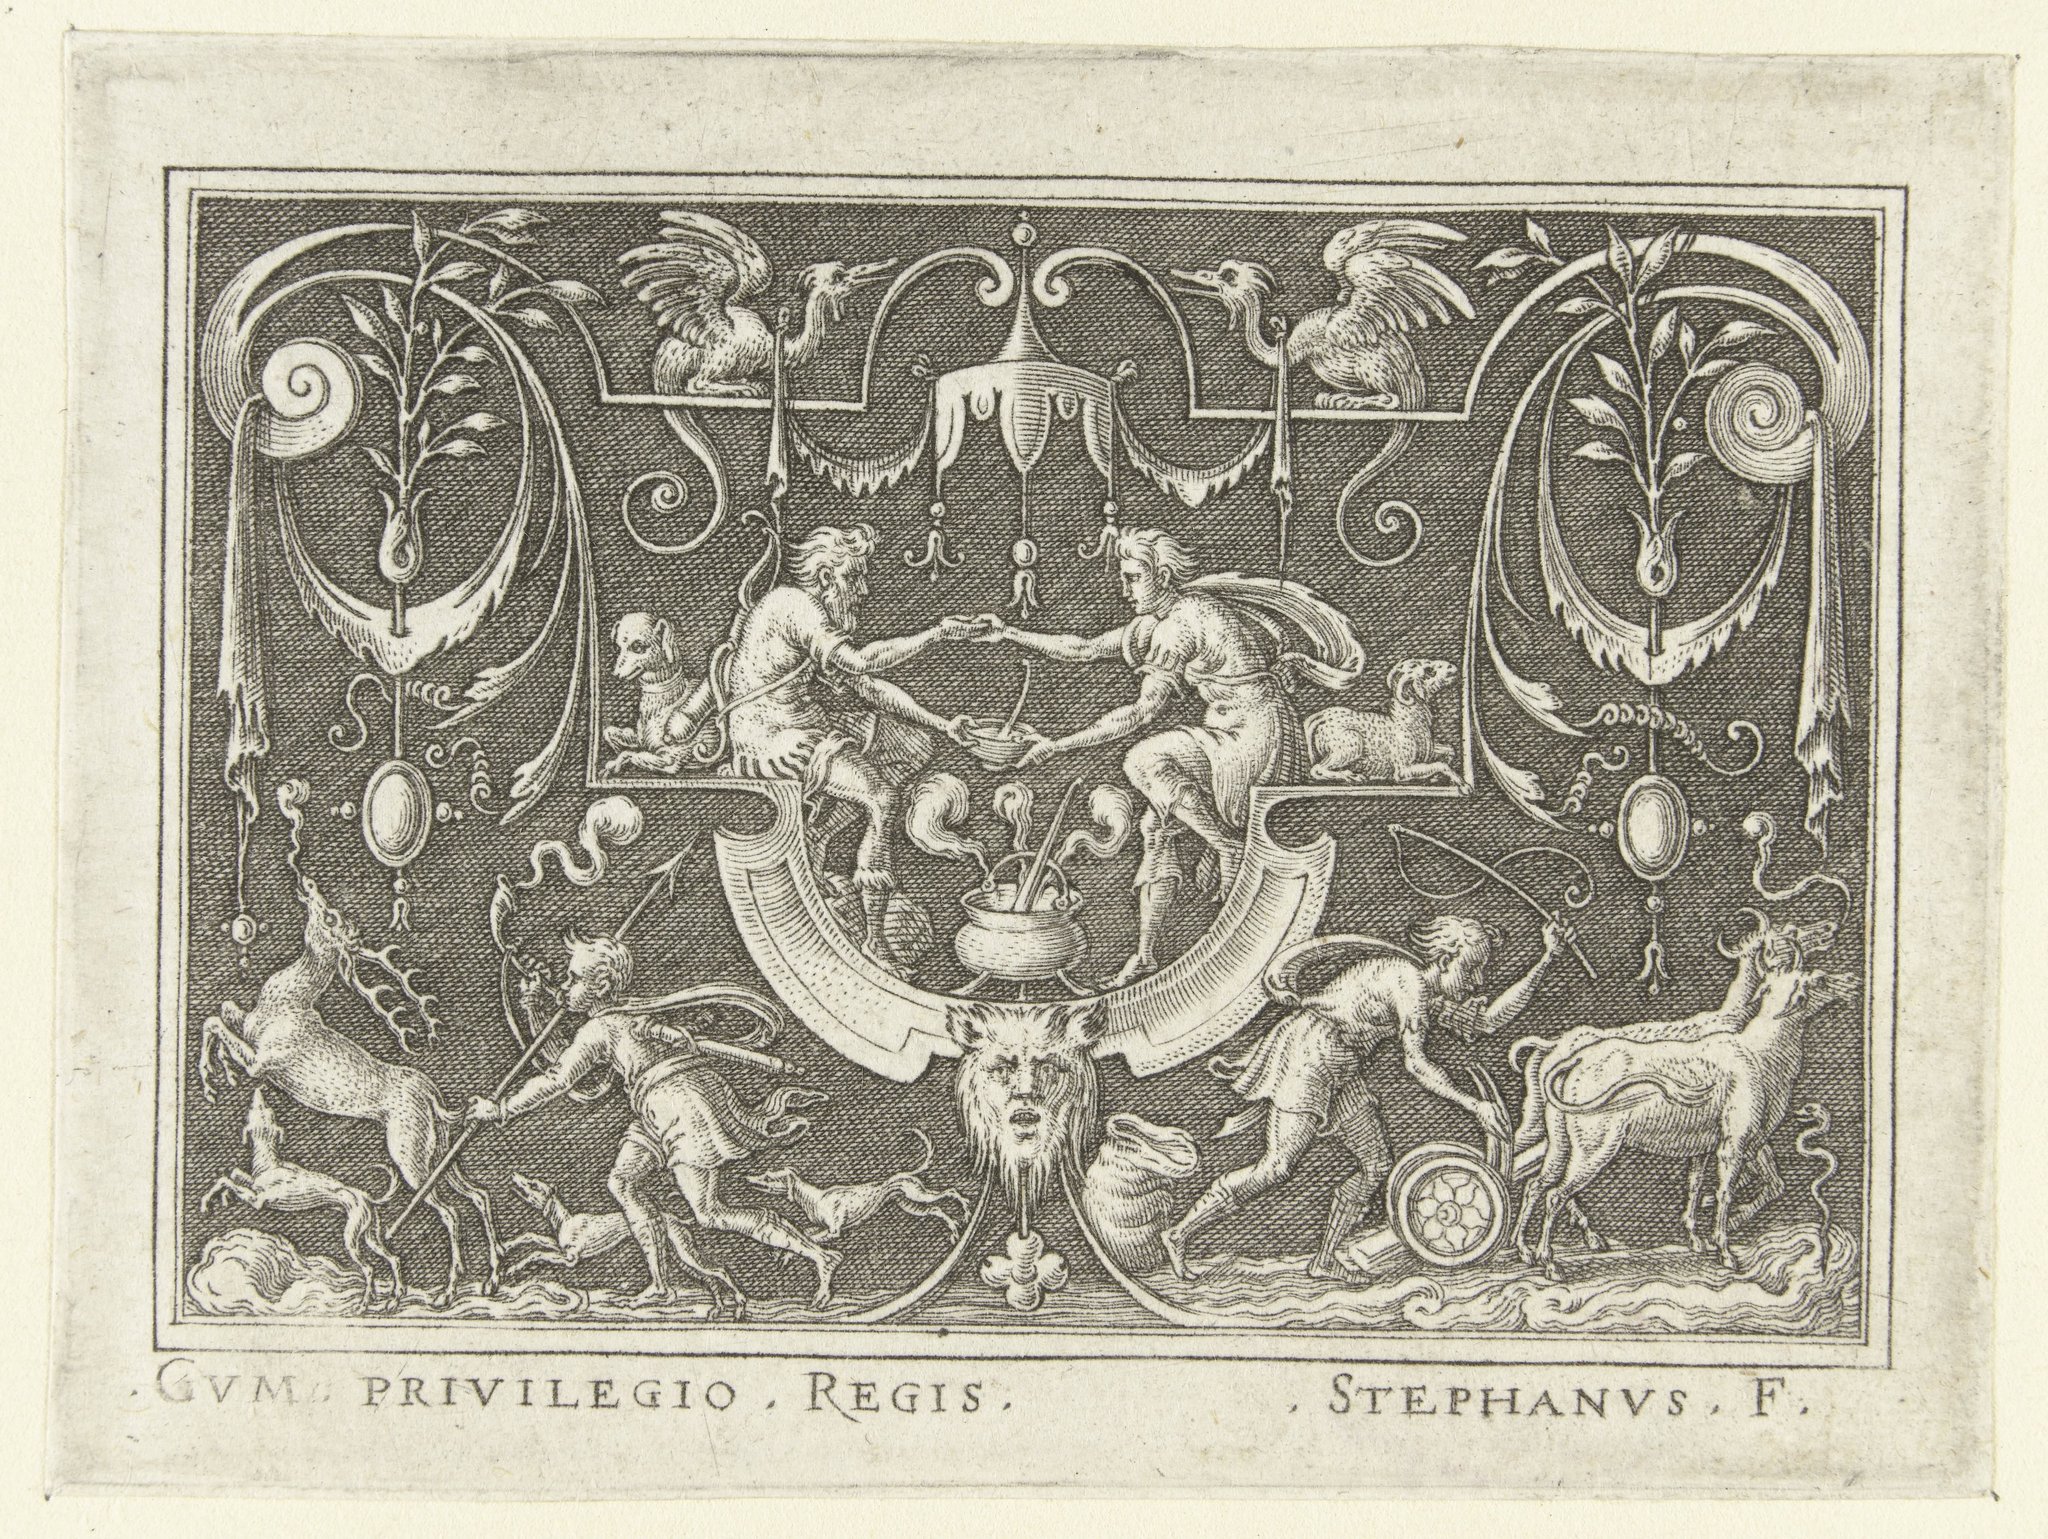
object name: ornament print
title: Vlakdecoraties met scènes uit het Oude Testament in een omlijsting van grotesken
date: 1528-1583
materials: paper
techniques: engraving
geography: france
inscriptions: collector's mark: Lugt 240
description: Beiden zitten in het midden tegenover elkaar met een kom in hun handen. Uit serie van 6 bladen.